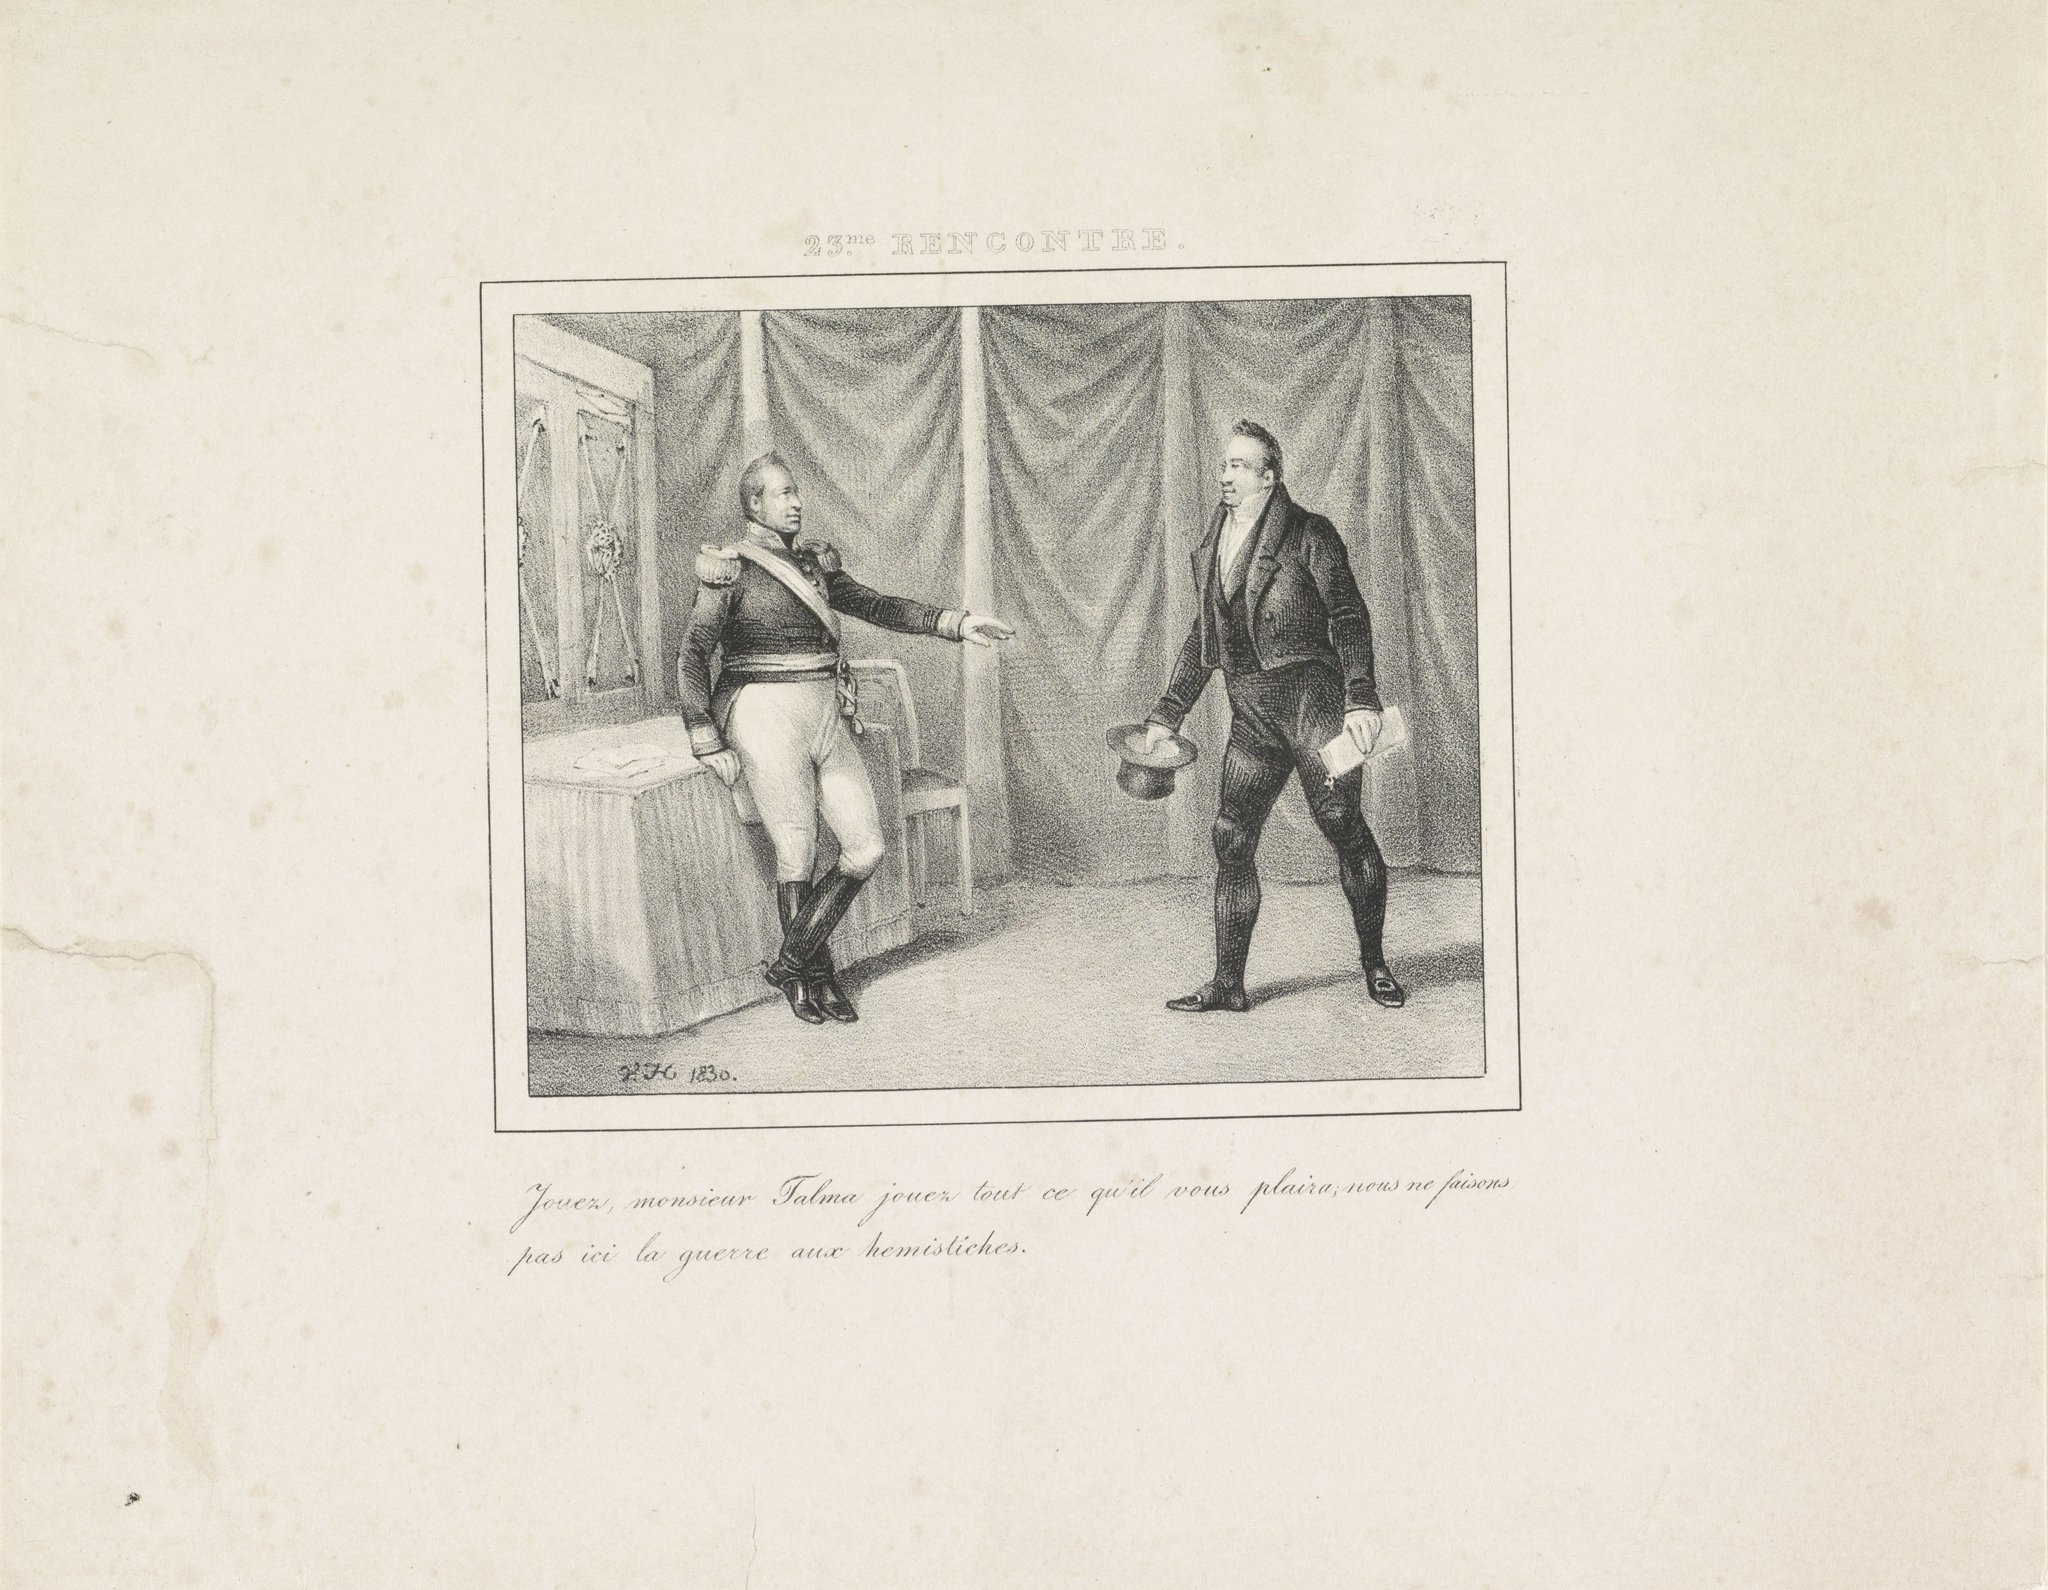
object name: print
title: Ontmoetingen met koning Willem I, 1829-1830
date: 1830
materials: paper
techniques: lithograph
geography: brussels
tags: paris, the hague, berlin, william i of the netherlands, ruler in informal contact with his subjects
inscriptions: collector's mark: Lugt 2228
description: De koning geeft Talma (mogelijk de acteur François-Joseph Talma) toestemming te spelen wat hij wil. Met tweeregelig onderschrift. Onderdeel van de serie van 24 platen met ontmoetingen met koning Willem I, verschenen onder de titel 'Les rencontres' in 1829-1830.